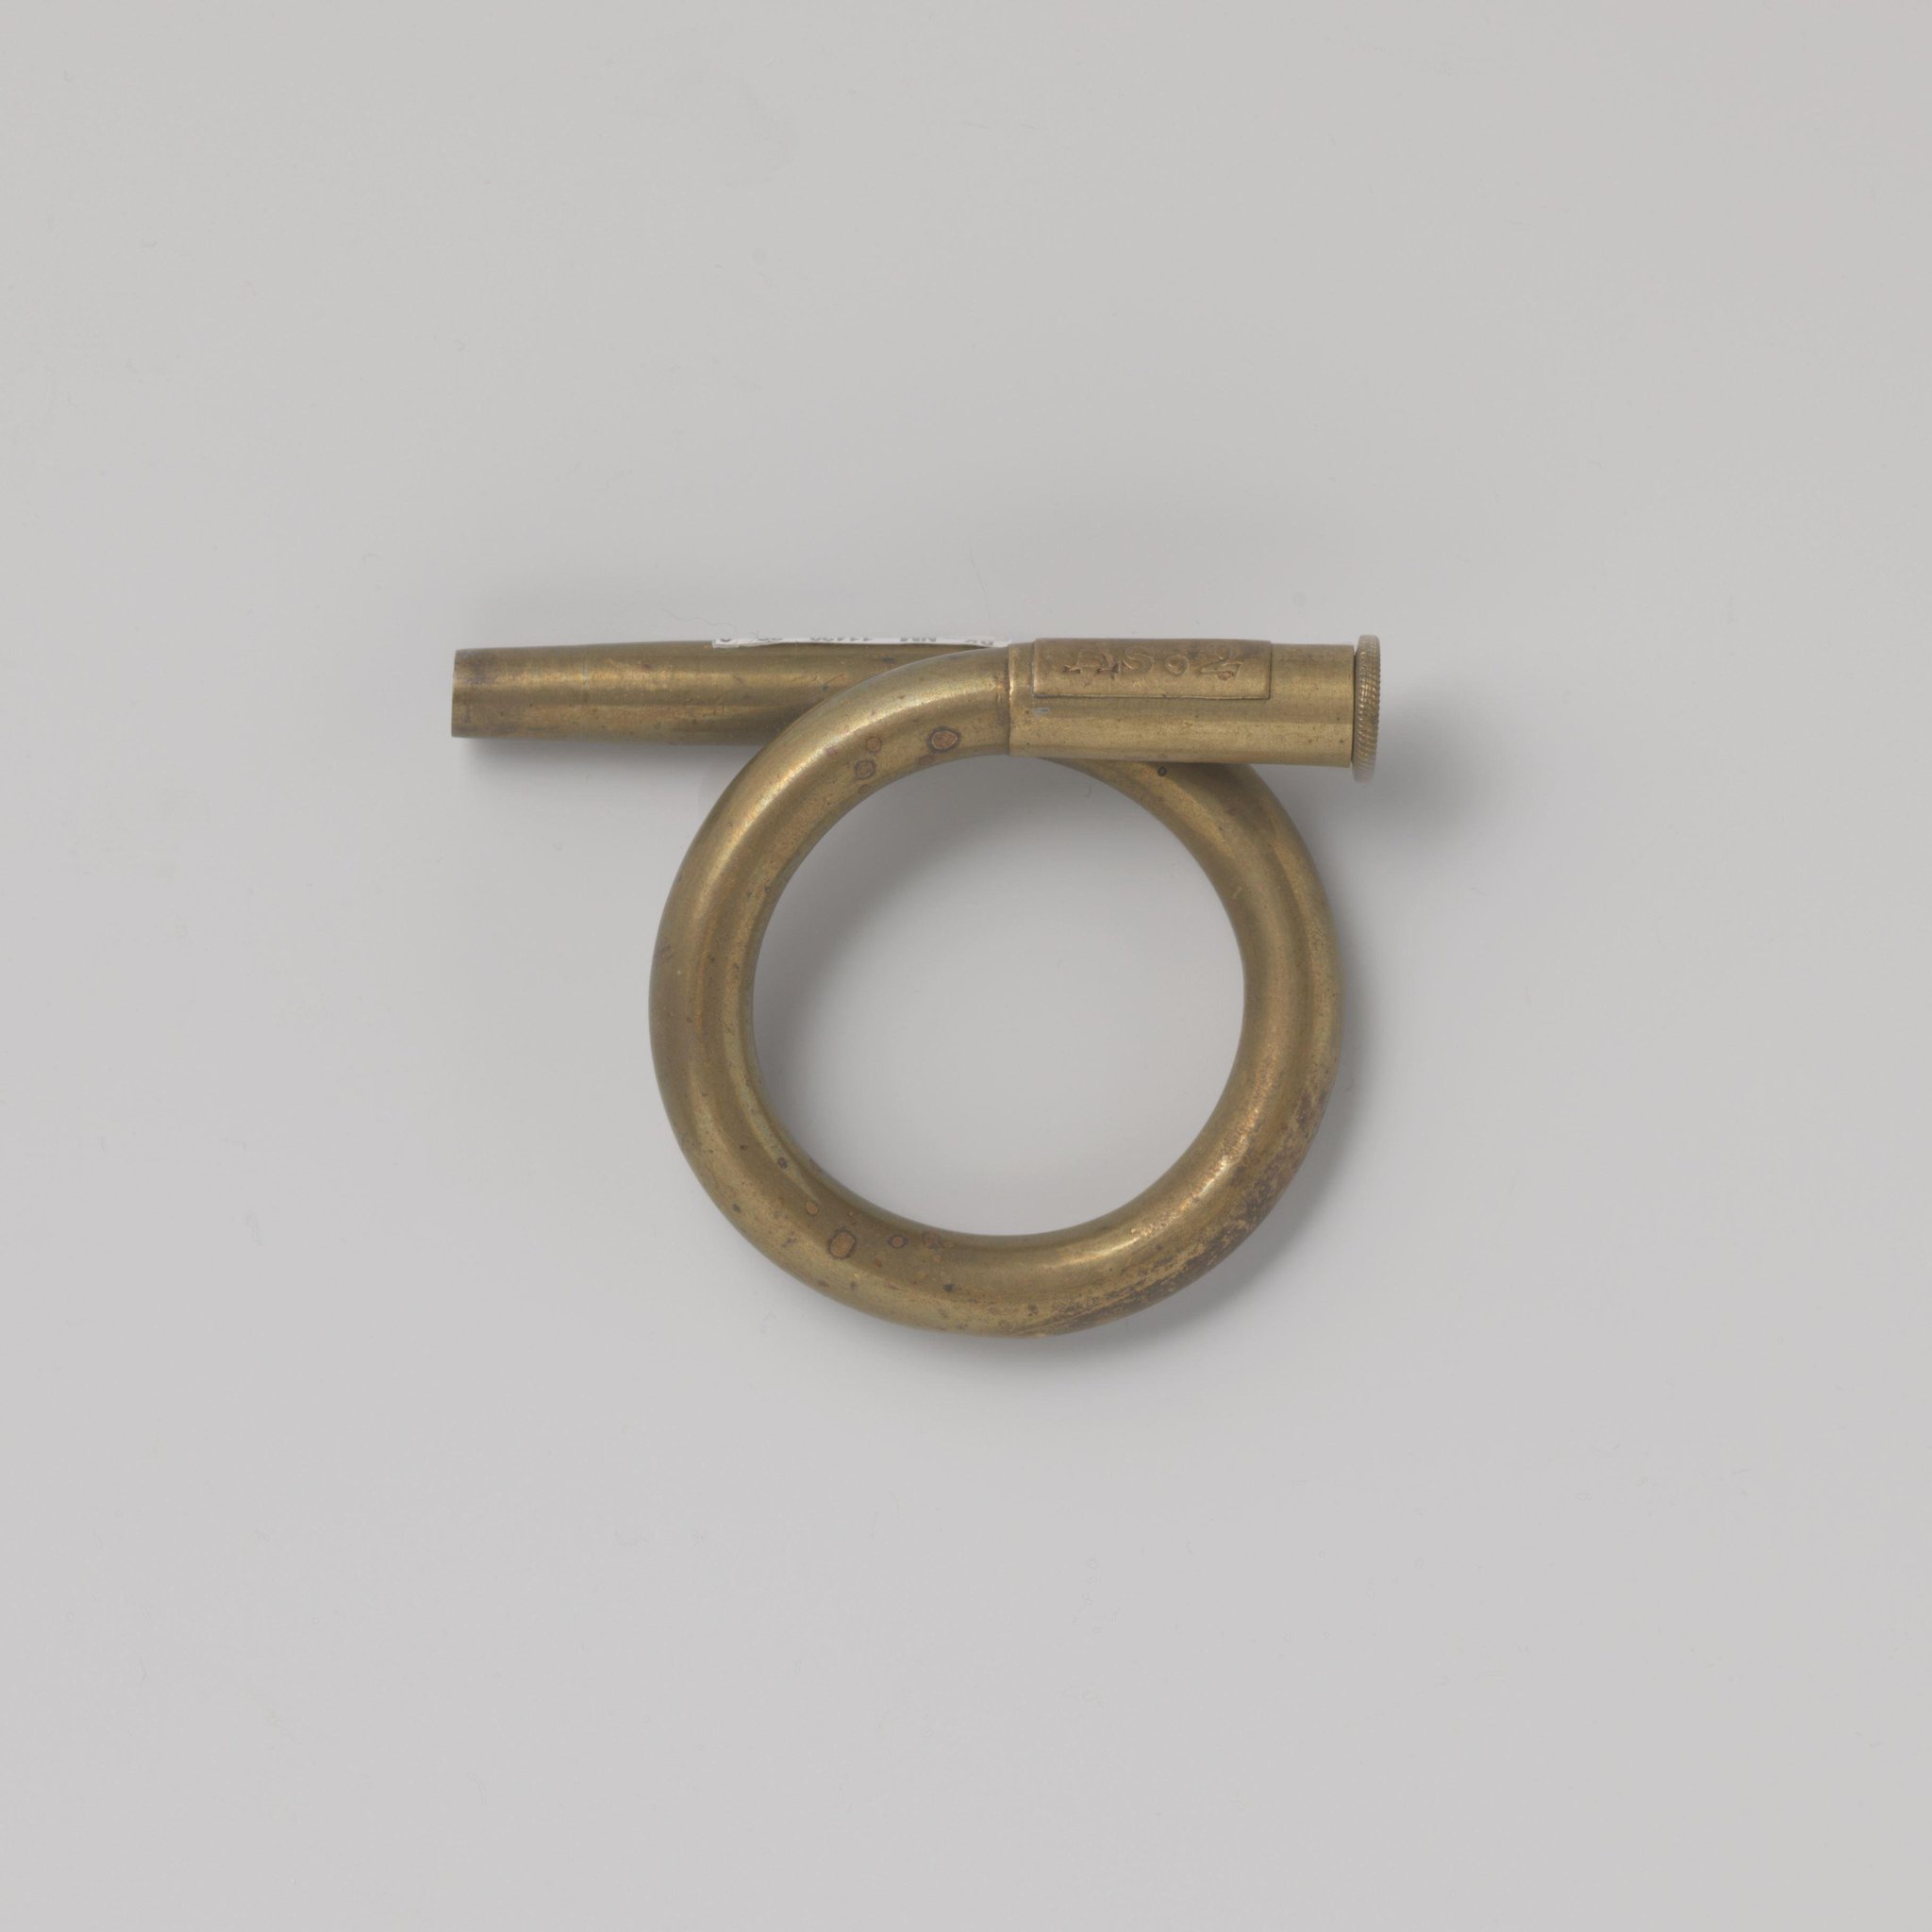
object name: horn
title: Invention horn crook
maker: carl gottlob schüster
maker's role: instrument maker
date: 1850-1950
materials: copper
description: Beugel van inventionshoorn. Gemerkt: As.2